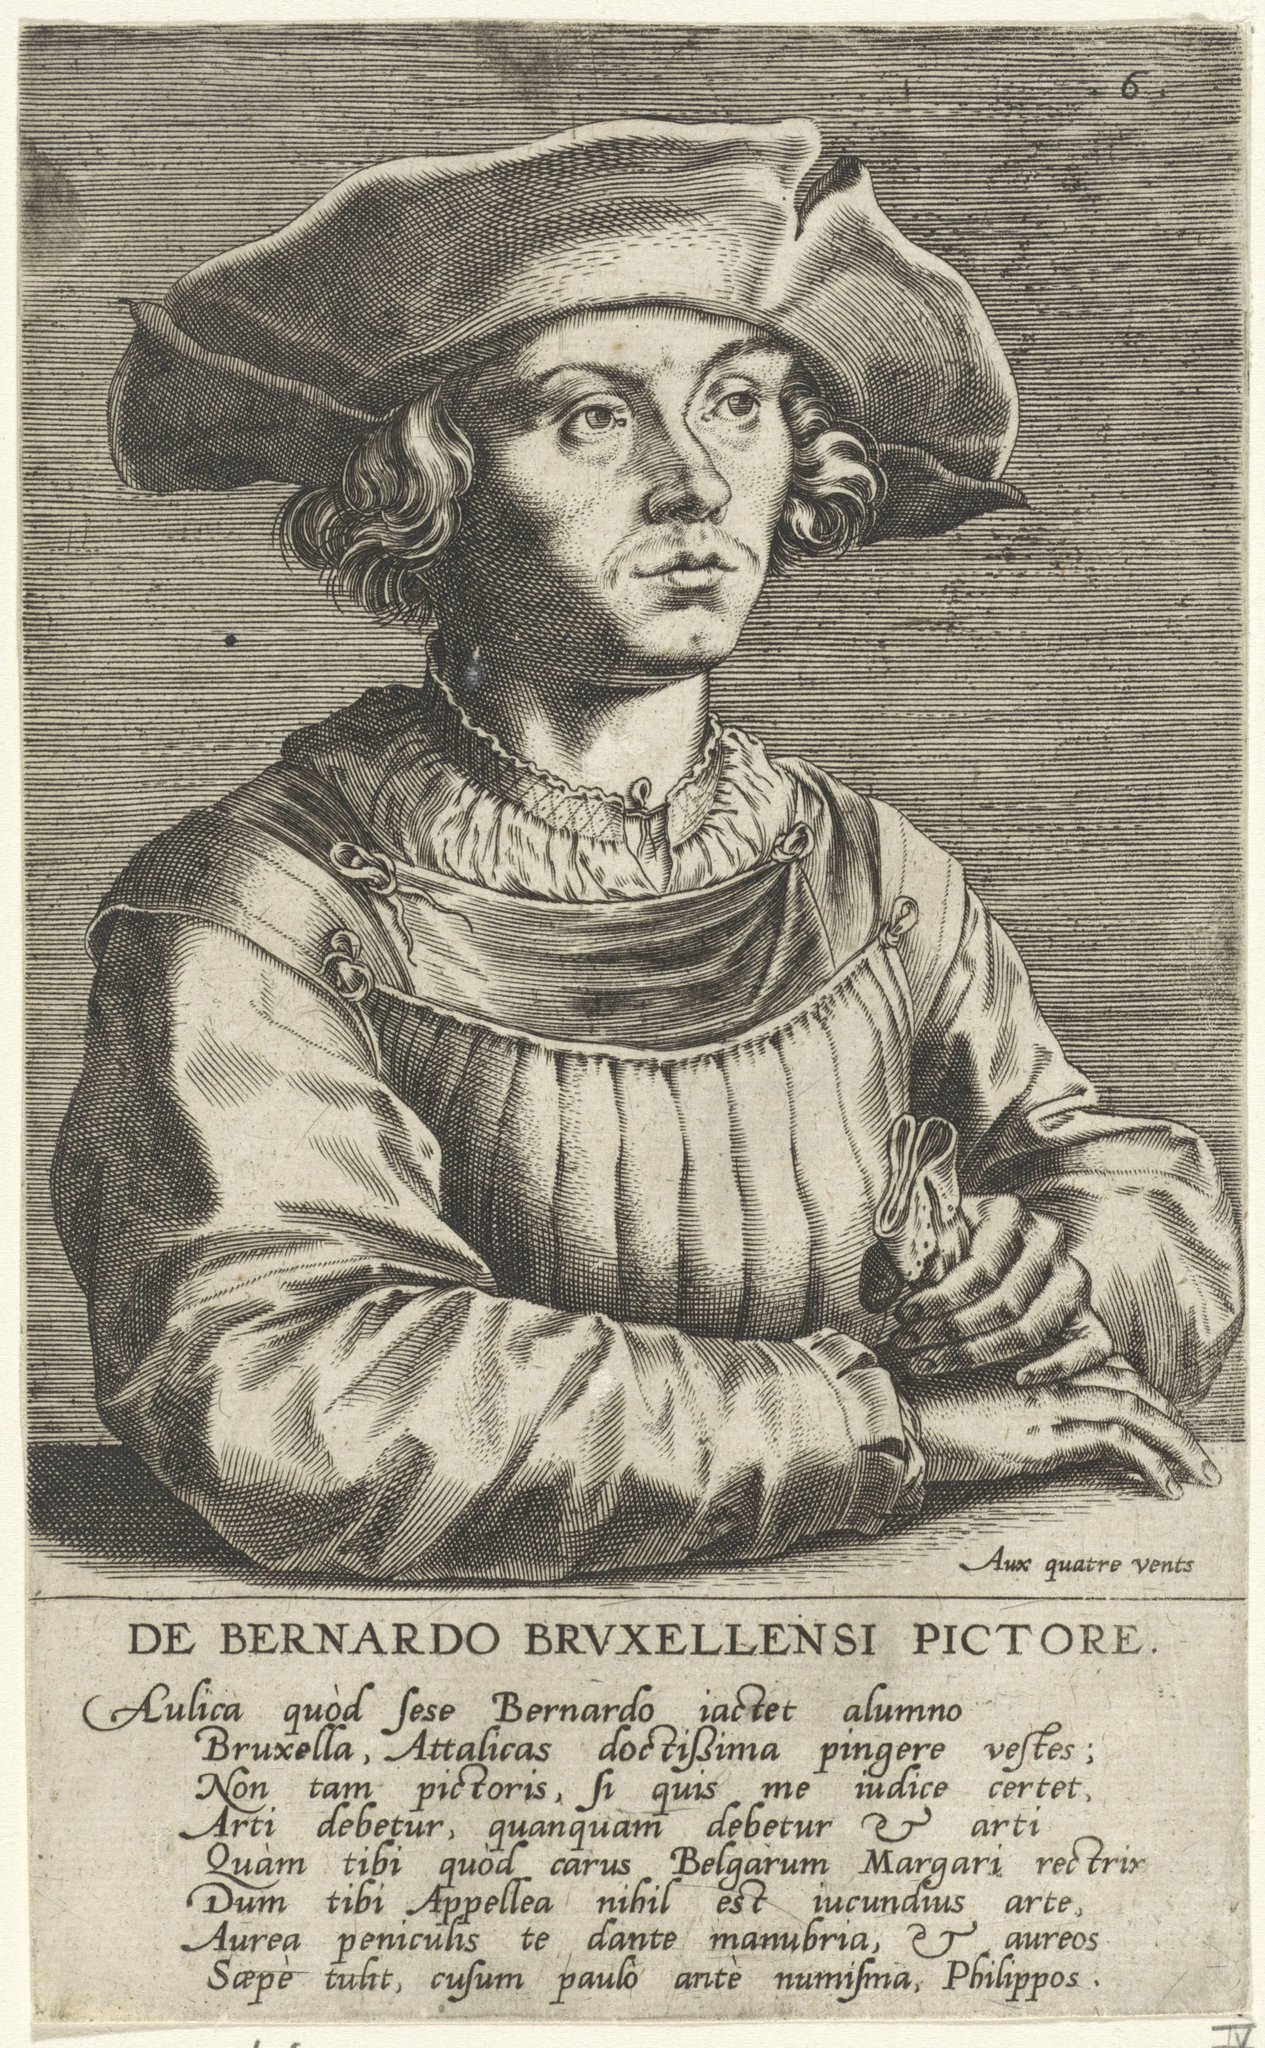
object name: print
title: Portretten van schilders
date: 1572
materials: paper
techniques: engraving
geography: antwerp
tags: brussels, draughtsman, bernard van orley, portrait, self-portrait of painter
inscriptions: collector's mark: Lugt 2228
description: In de marge een achtregelig onderschrift in het Latijn.